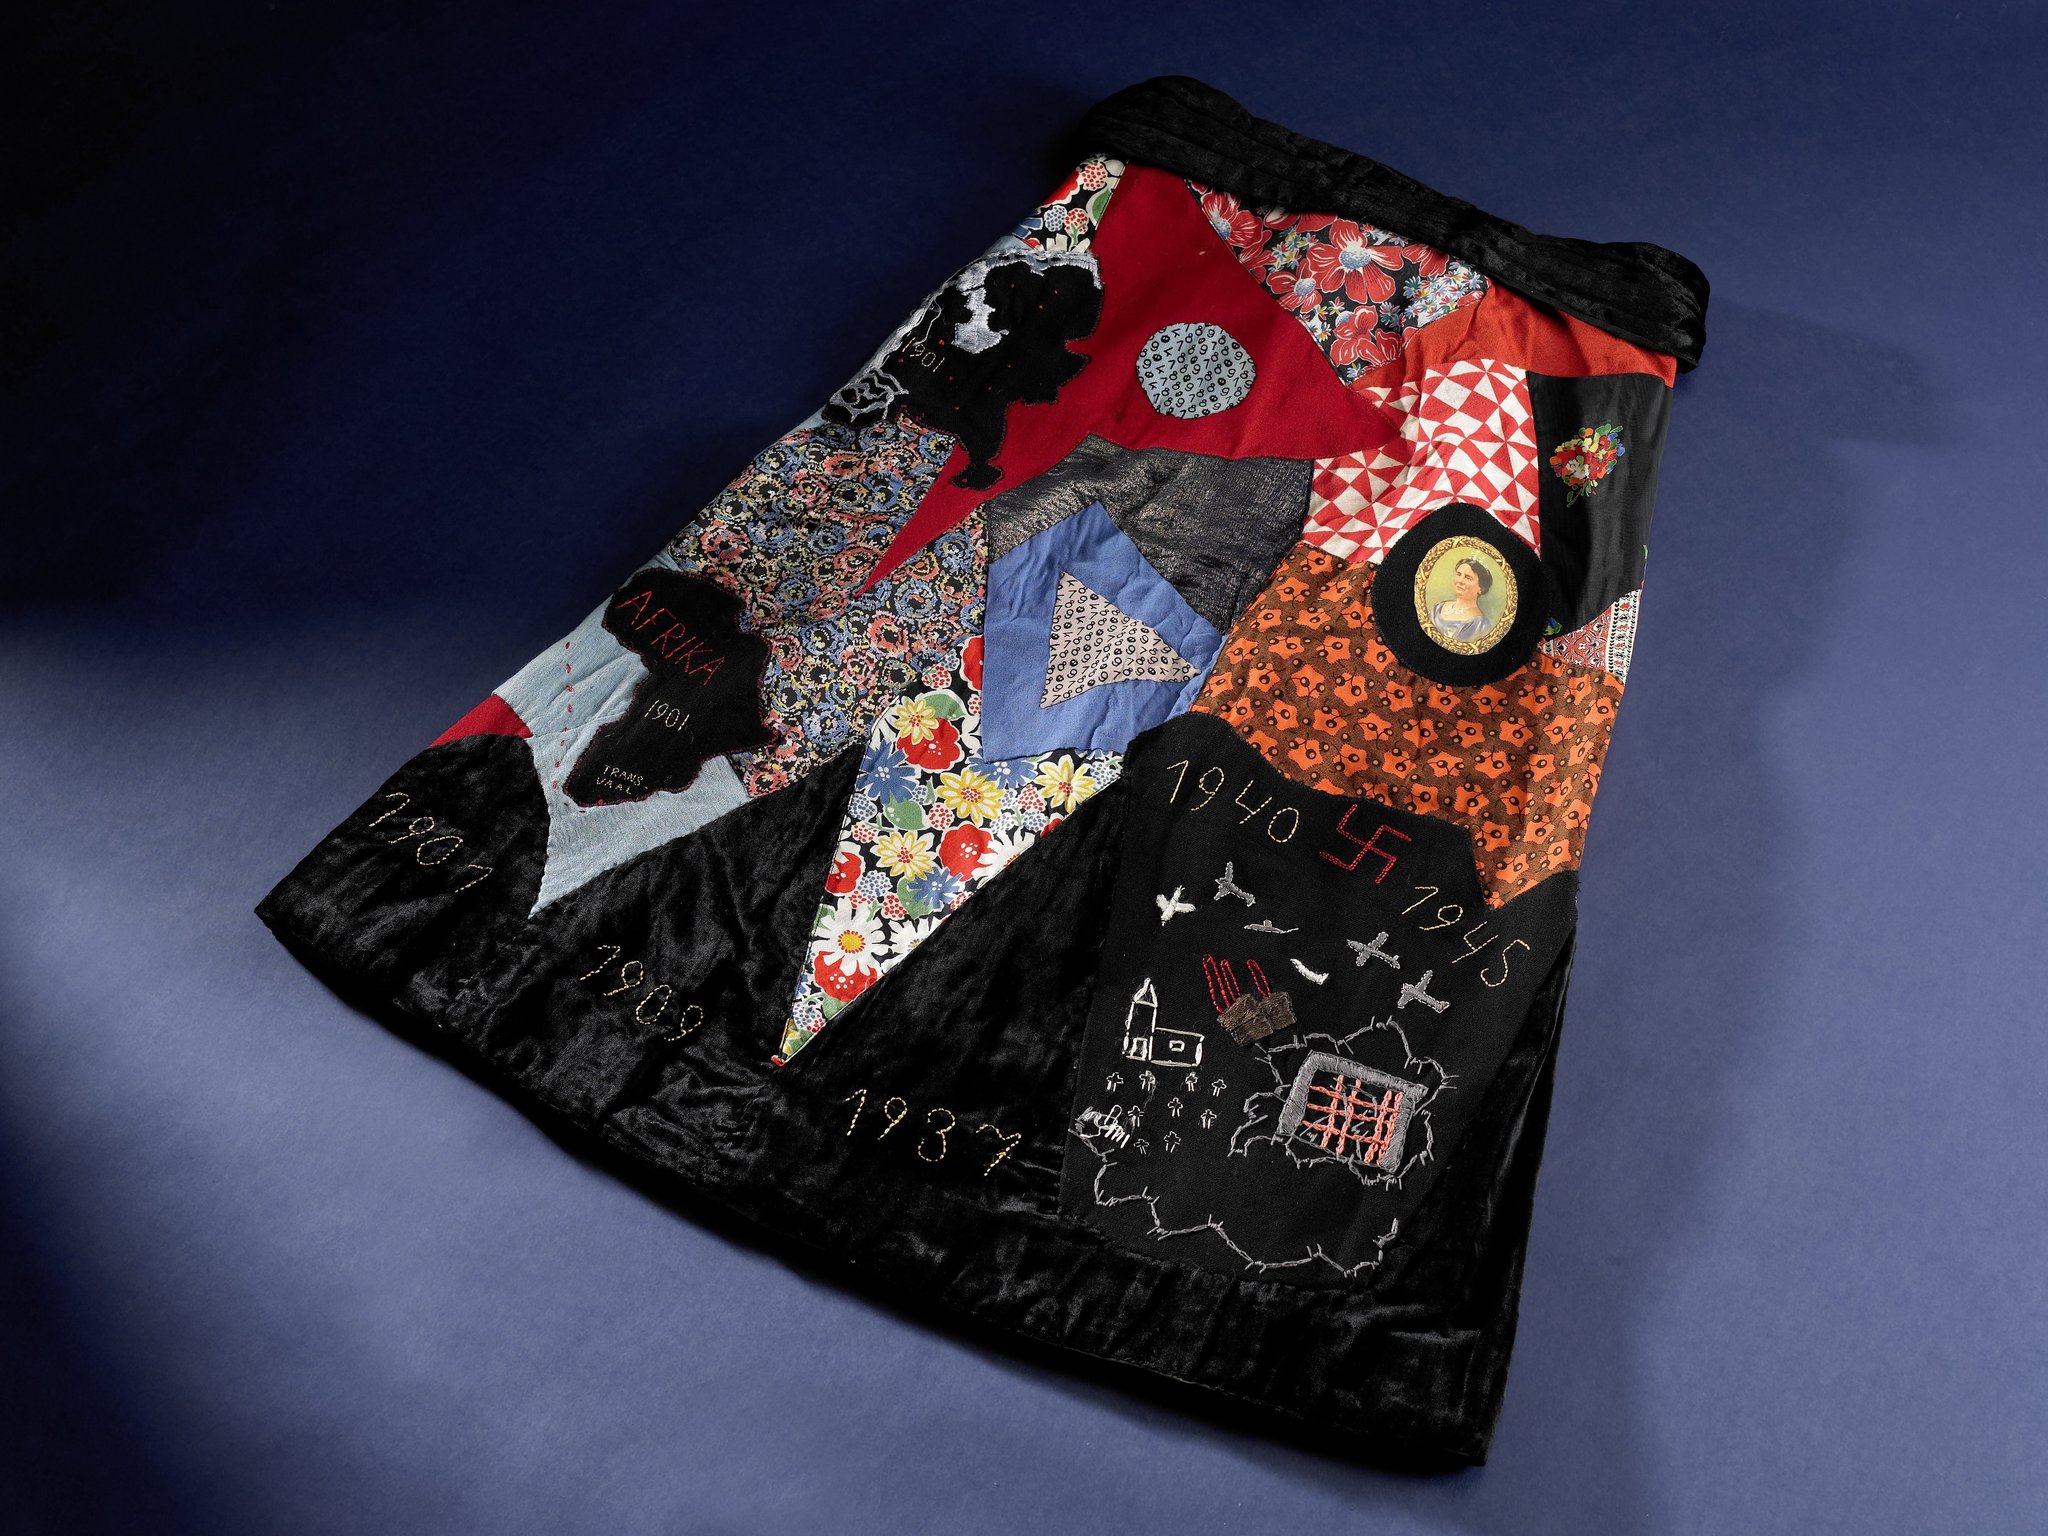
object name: skirt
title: Nationale feestrok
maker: c.e. de visser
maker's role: linnennaaister, naaister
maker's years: 1914-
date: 1945-1960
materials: cotton, plastic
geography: netherlands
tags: amsterdam, netherlands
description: Een Nationale Feestrok gemaakt in het kader van de bevrijding van Nederland om te dragen op nationale feestdagen en ter herinnering aan diverse gebeurtenissen tijdens de Tweede Wereldoorlog. Bij de rok hoort een oranje sjerp en een zwarte ceintuur. Op de rok zelf zijn diverse gebeurtenissen afgebeeld, geborduurd, zoals: 1948 - 50 jaar Wilhelmina (met portret), 1940 - 1945 met vliegtuigen en vogels, een gevangenis met prikkeldraad en een kerkje met een kerkhof, kaart van Nederland en kaart van Zuid Afrika met daartussen het schip De Gelderland waarmee Paul Kruger naar Nederland voer en de jaartallen 1901 en 1901. Portretjes van de vier prinsessen, Beatrix, Irene, Margriet en Marijke met hun geboortejaartal. Op de zoom van de rok de jaartallen: 1901, 1909, 1937, 1898, 1948. Geborduurd het stempel van de Nationale Feestrok met het jaar 1948 en NI (Nationaal Instituut) en de zin: Saamgevoegd op een ondergrond. Bij de rok hoort een kaartje met het adres van de maakster en een nummer: Uw feestrok is onder nummer 2360 ingeschreven in het rokkenregister van het Nationaal Instituut (thans IIAV).